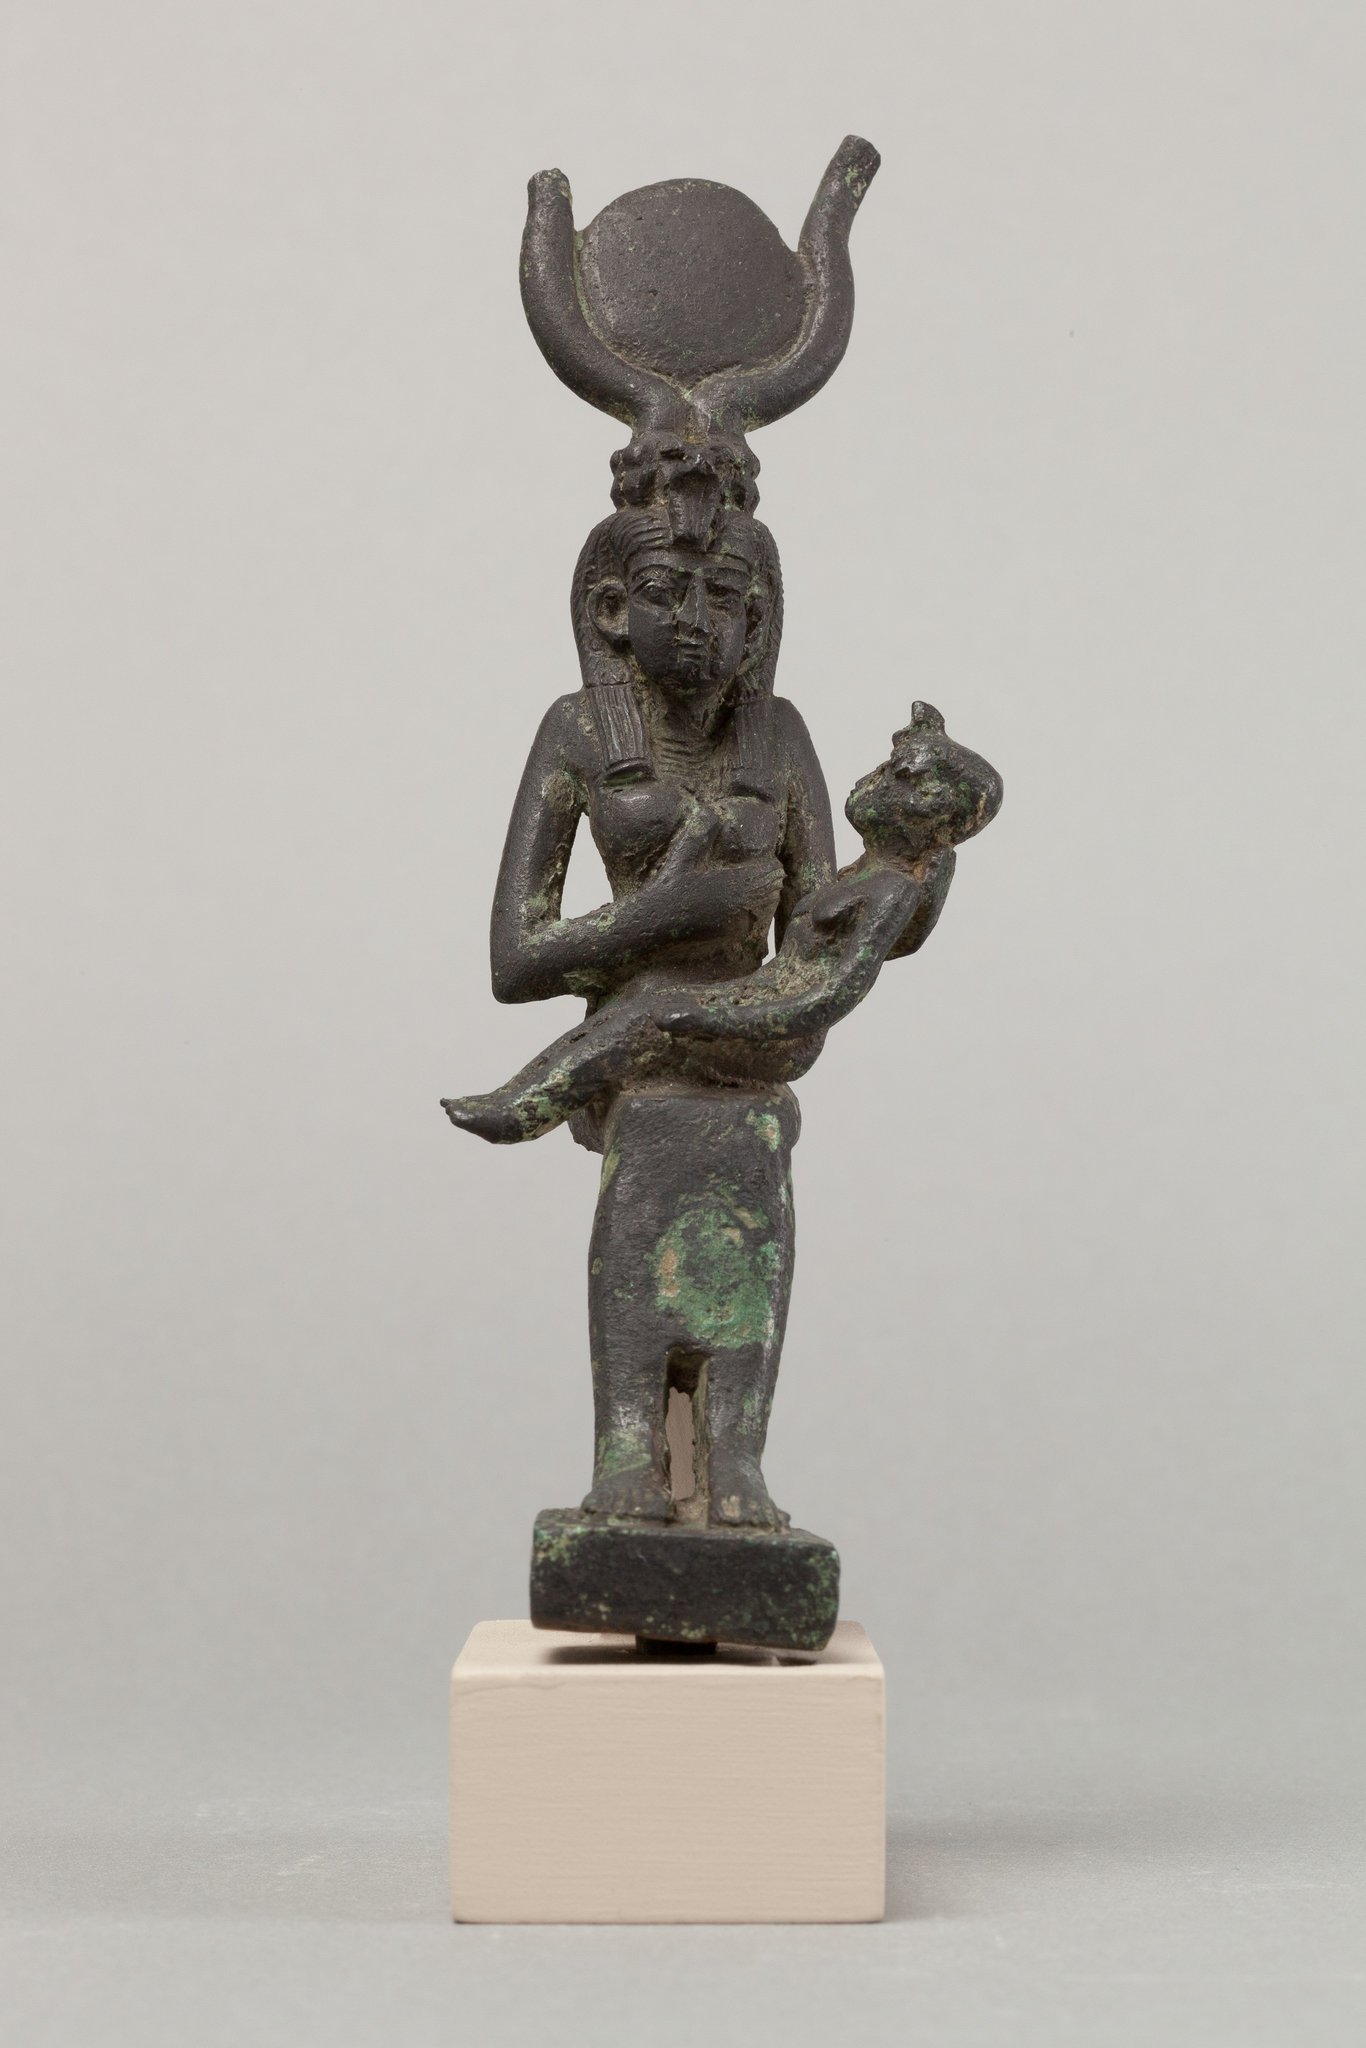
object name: statuette, isi, horus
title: Isis and Horus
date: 664-630 BCE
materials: metal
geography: egypt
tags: horus,isis,nursing